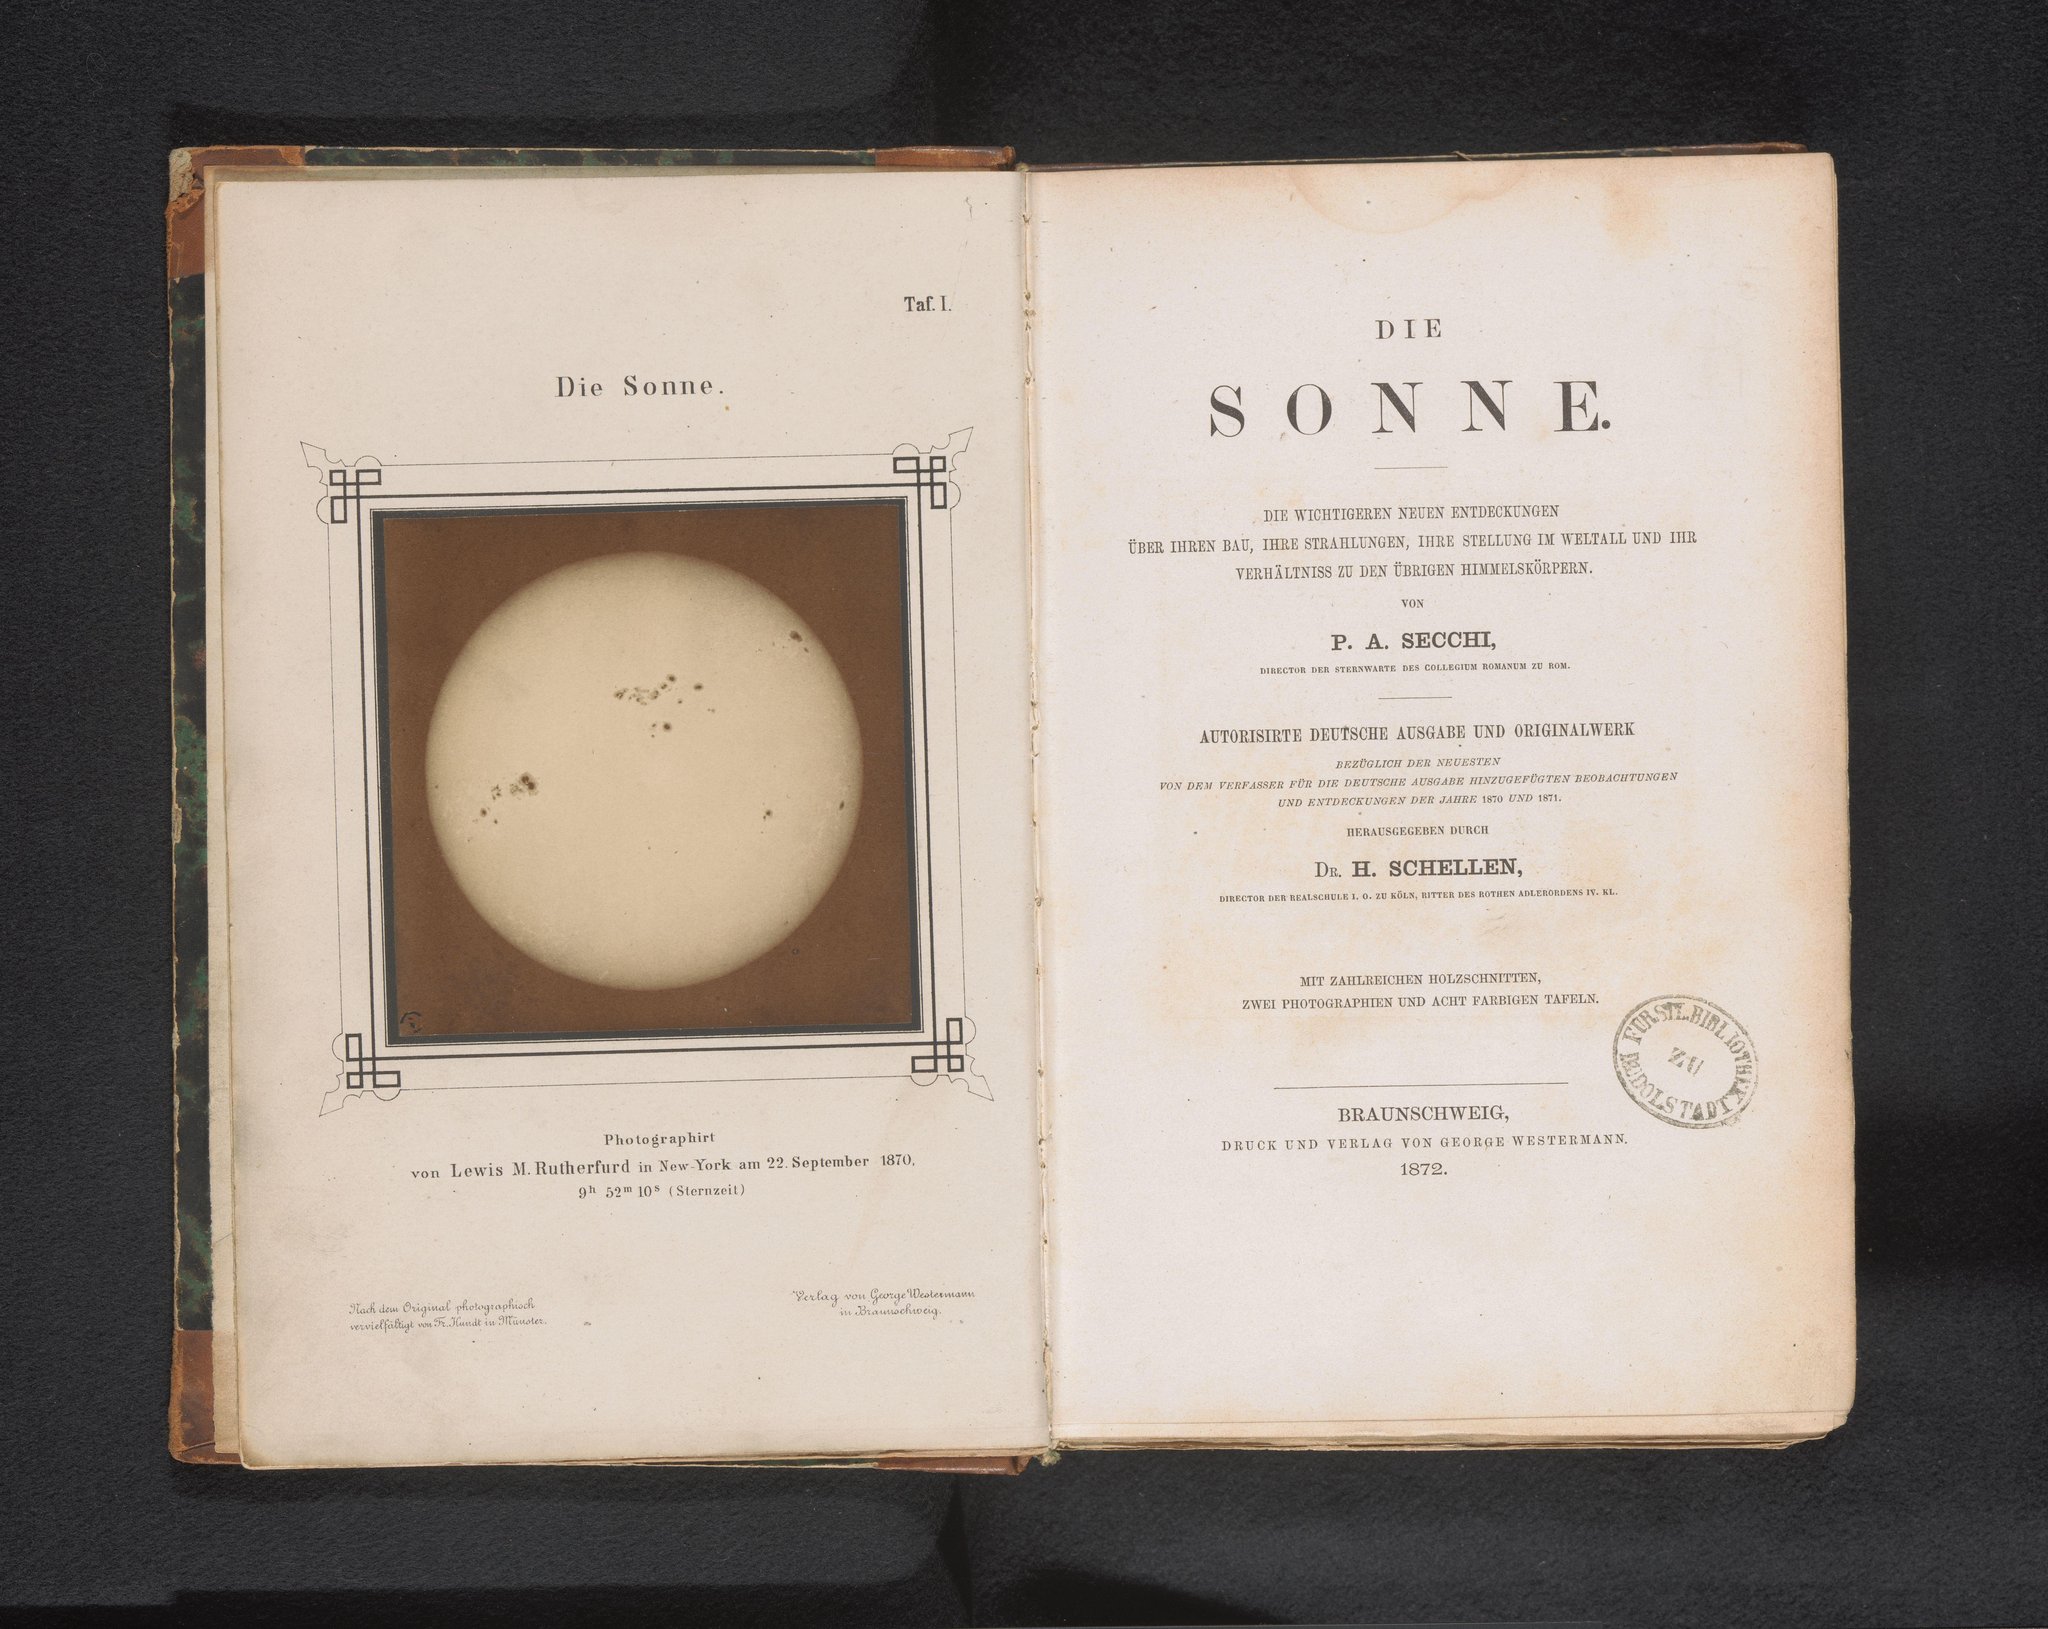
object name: book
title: Die Sonne die wichtigeren neuen Entdeckungen über ihren Bau, ihre Strahlungen, ihre Stellung im Weltall und ihr Verhältniss zu den übrigen Himmelskörpern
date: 1872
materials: leather, paper, photographic support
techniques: marbled paper, albumen print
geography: braunschweig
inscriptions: number: ‘Bi. 6.’